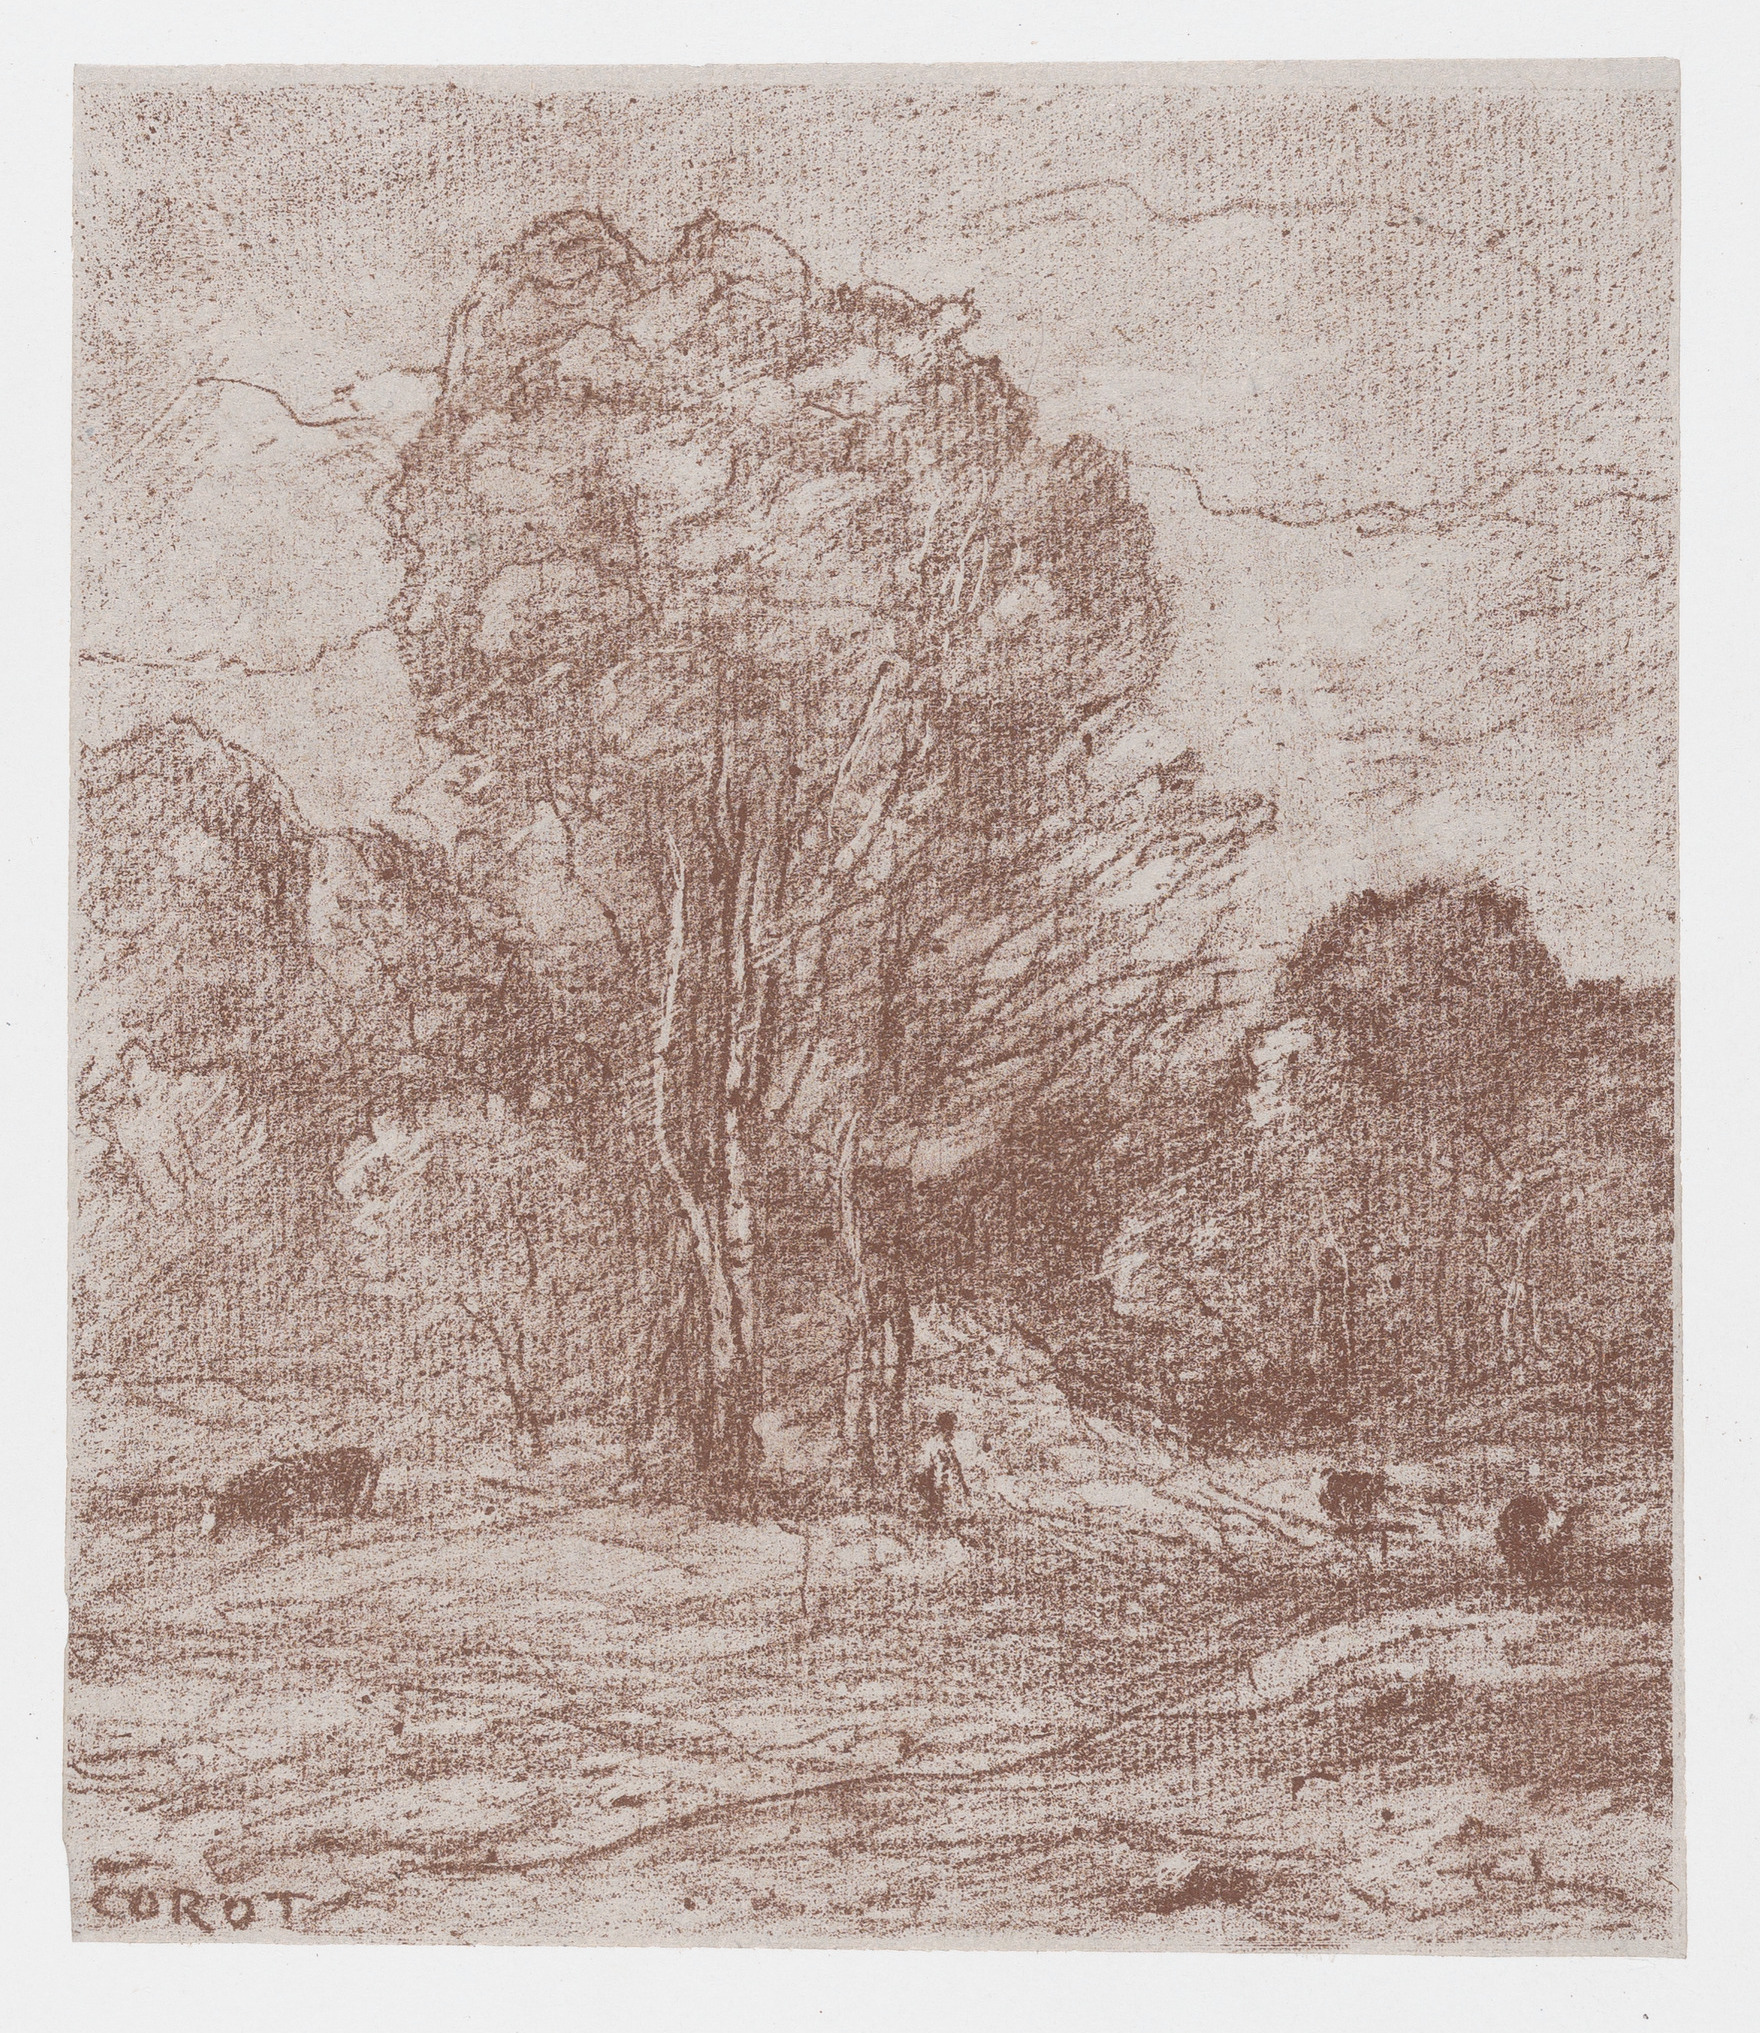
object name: print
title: The Cows' Resting Place (Le Dormoir des vâches)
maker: jean-baptiste-camille corot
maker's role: artist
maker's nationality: french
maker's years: 1796-1875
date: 1871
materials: ink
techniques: printmaking, printing, lithography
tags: human figures,cows,trees